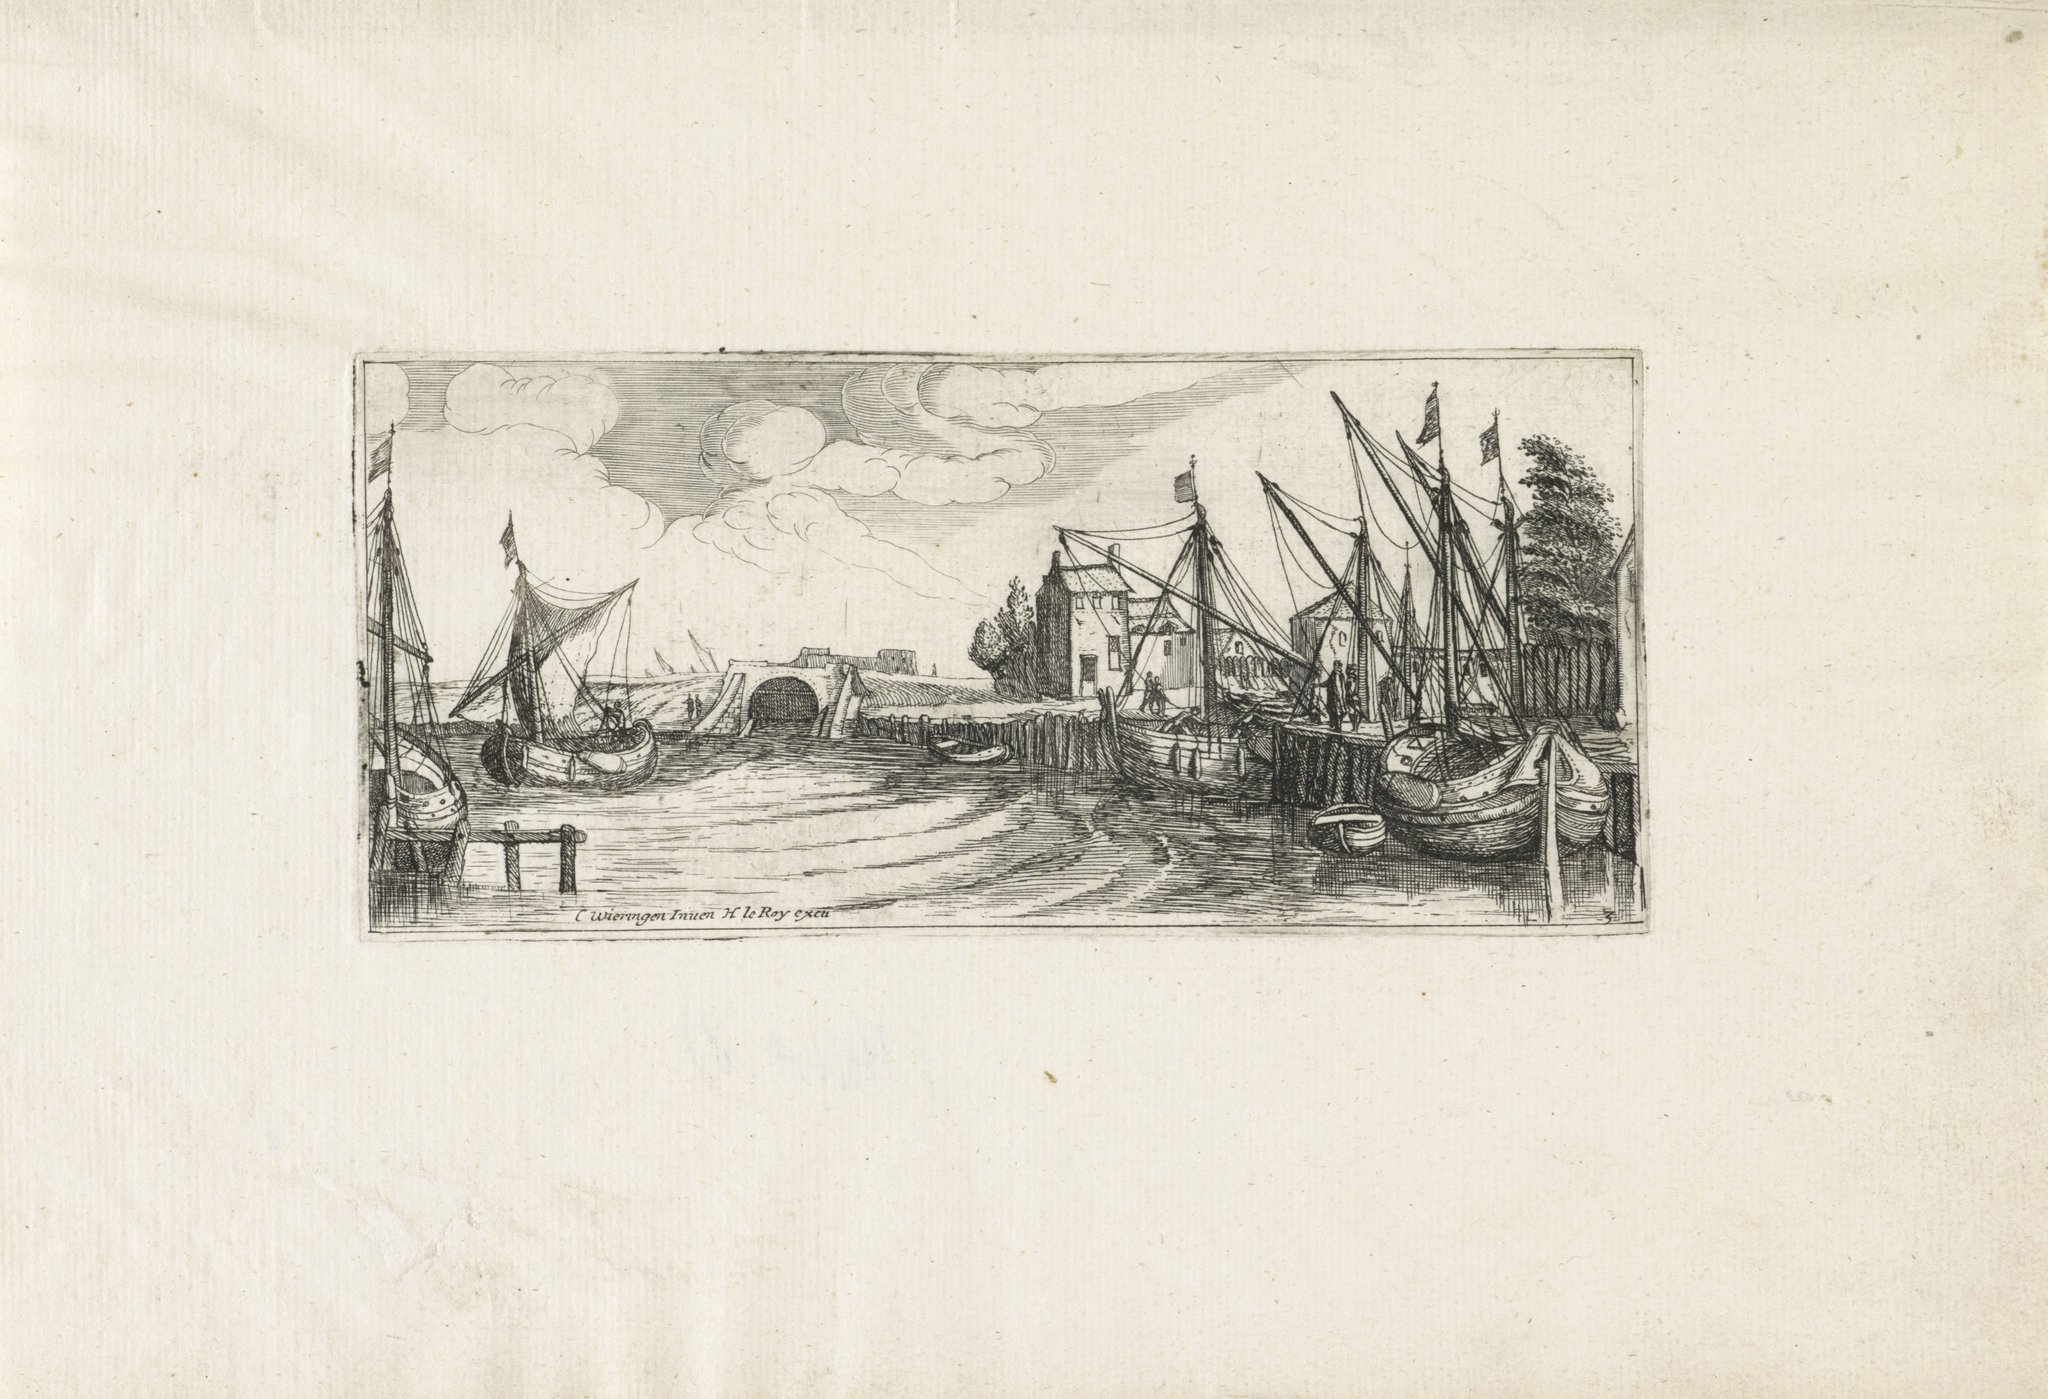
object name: print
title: Landschappen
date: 1614-1618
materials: paper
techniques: etching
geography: haarlem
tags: harbour, sluice, weir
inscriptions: collector's mark: Lugt 2228, collector's mark: Lugt 2760